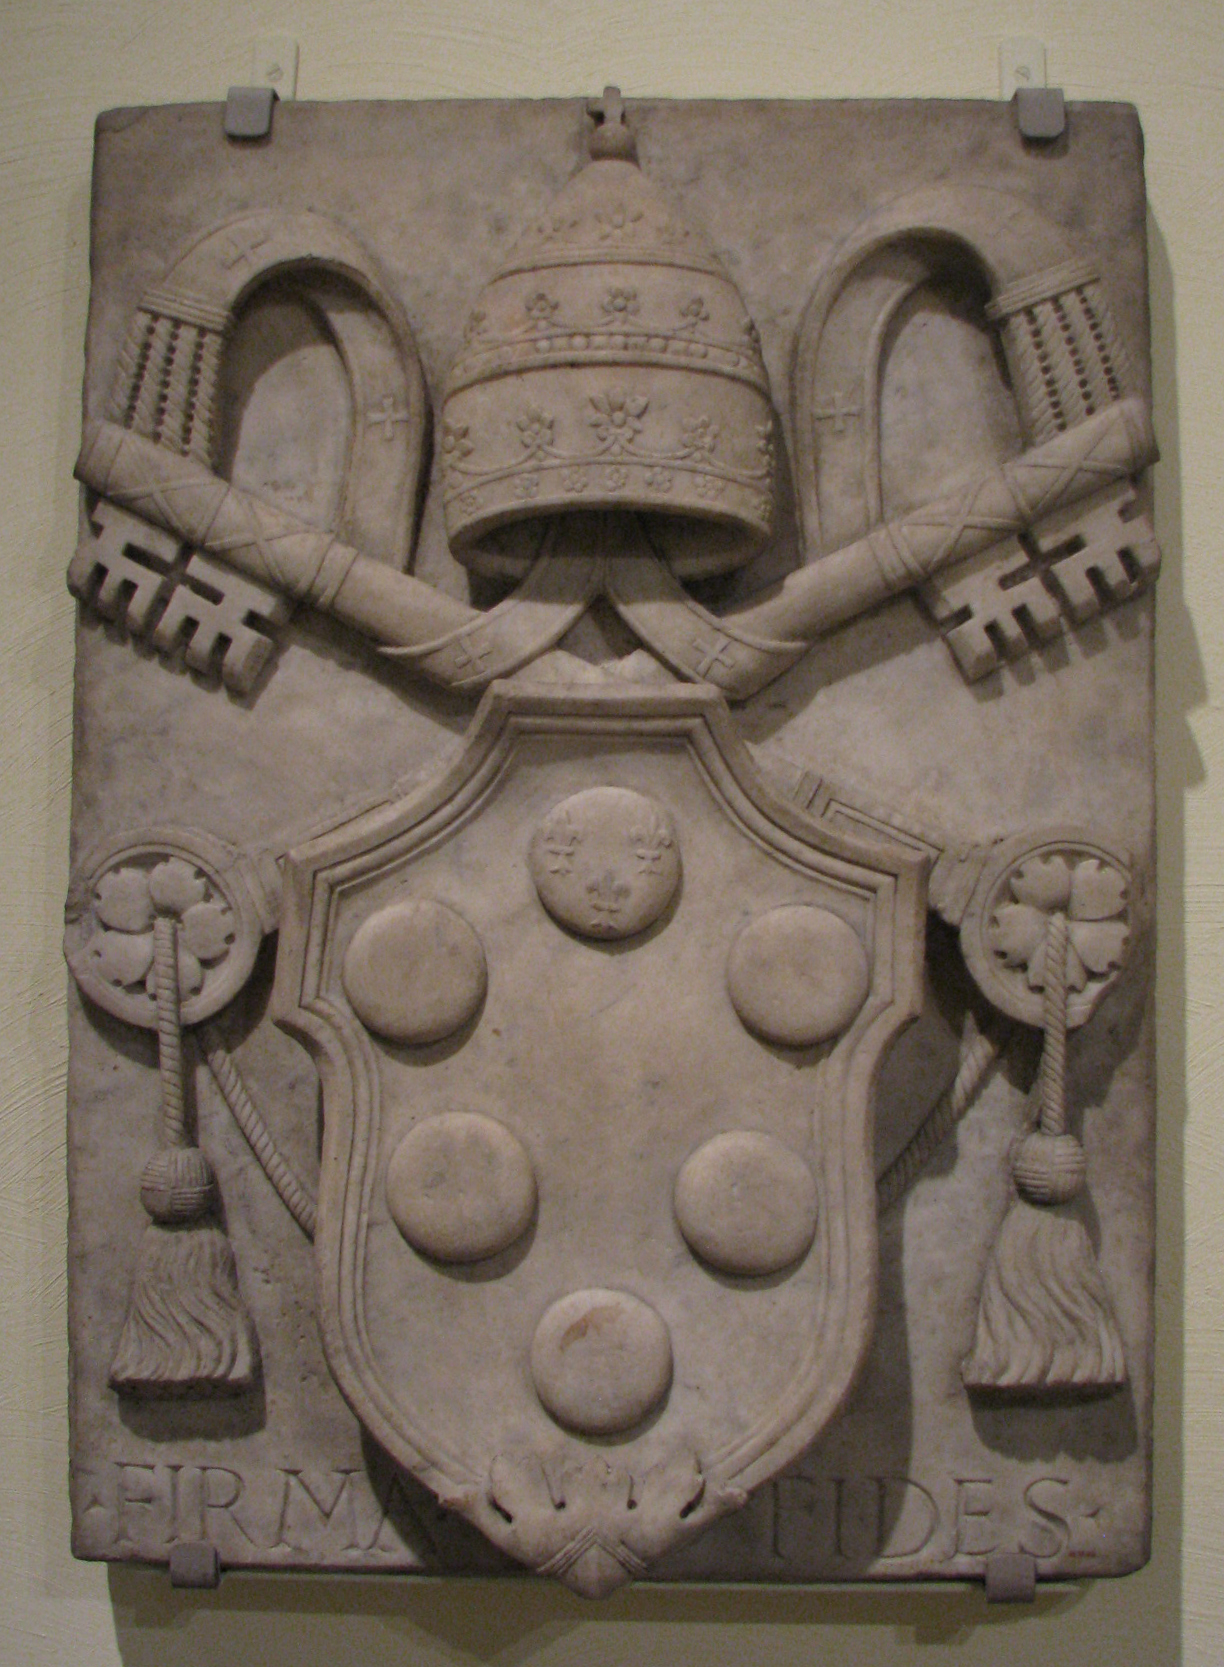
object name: papal arm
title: Arms of Pope Pius IV (Giovanni Angelo Medici of Milan, reigned 1559–65)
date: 1534-1566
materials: marble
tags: coat of arms